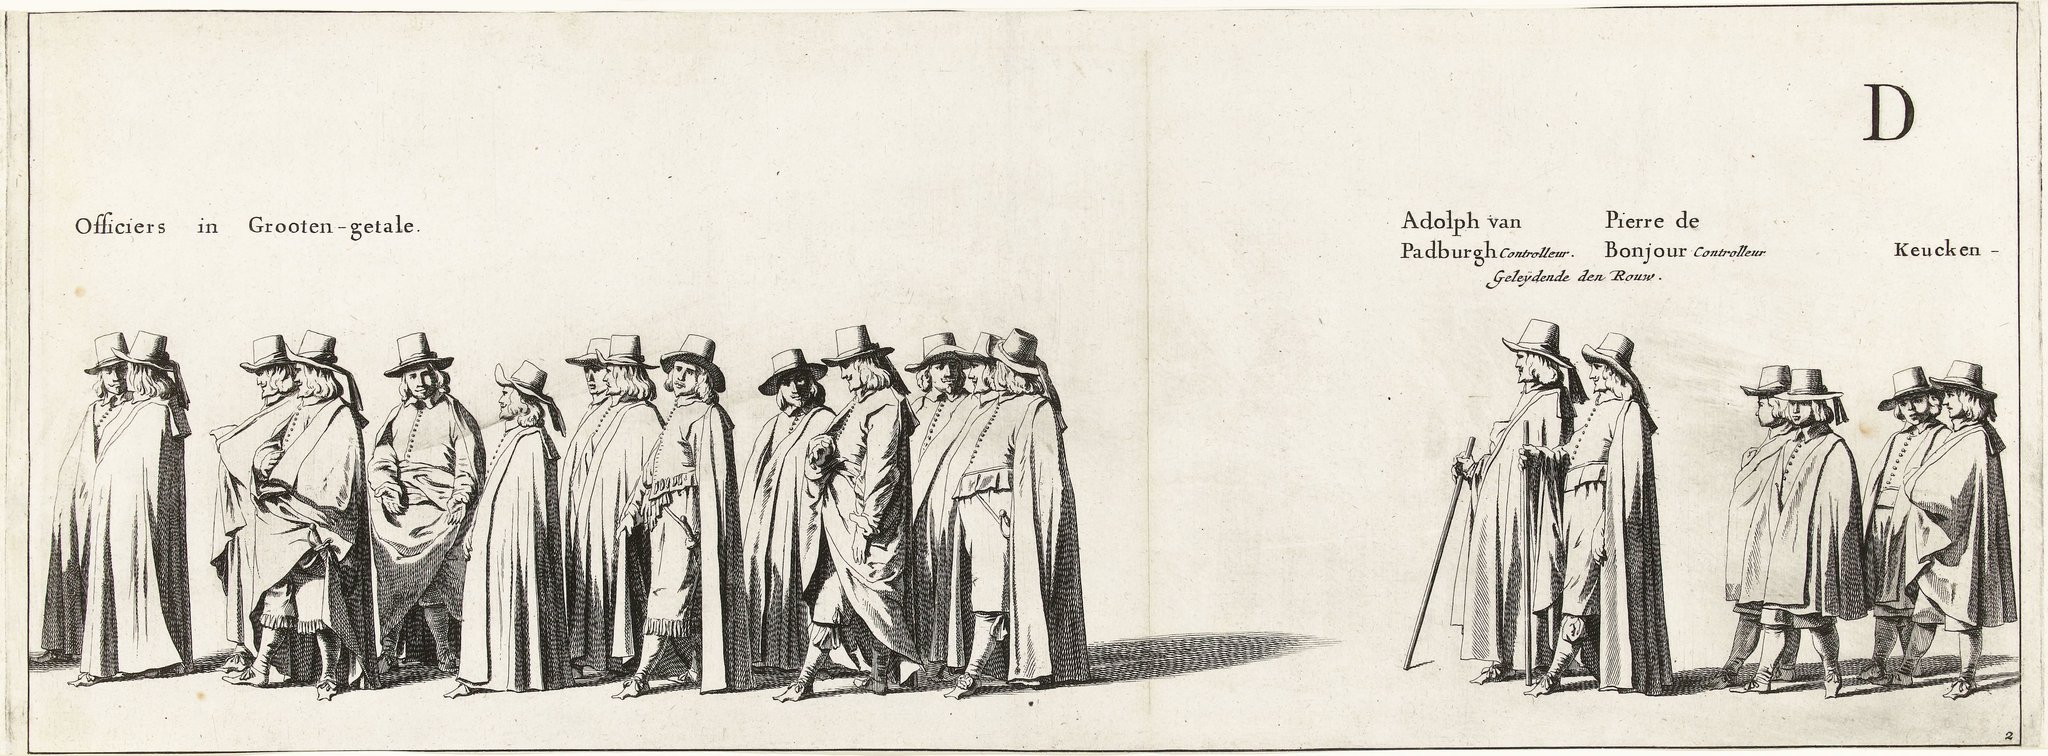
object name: print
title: Begraeffenisse van Syne Hoogheyt Frederick Henrick, by der Gratien Gods Prince van Orange, Grave van Nassau &c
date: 1647-1651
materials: paper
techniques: etching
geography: amsterdam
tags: delft, the hague, frederick henry (prince of orange), cortege, funeral procession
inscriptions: collector's mark: Lugt 2228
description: De begrafenisstoet van stadhouder Frederik Hendrik te 's-Gravenhage op 10 mei 1647. Plaat nr. 2 met een deel van de stoet, boven de personen staat hun functie. Onderdeel van een serie van 30 platen en 20 tekstbladen, bedoeld om aan elkaar geplakt te worden.